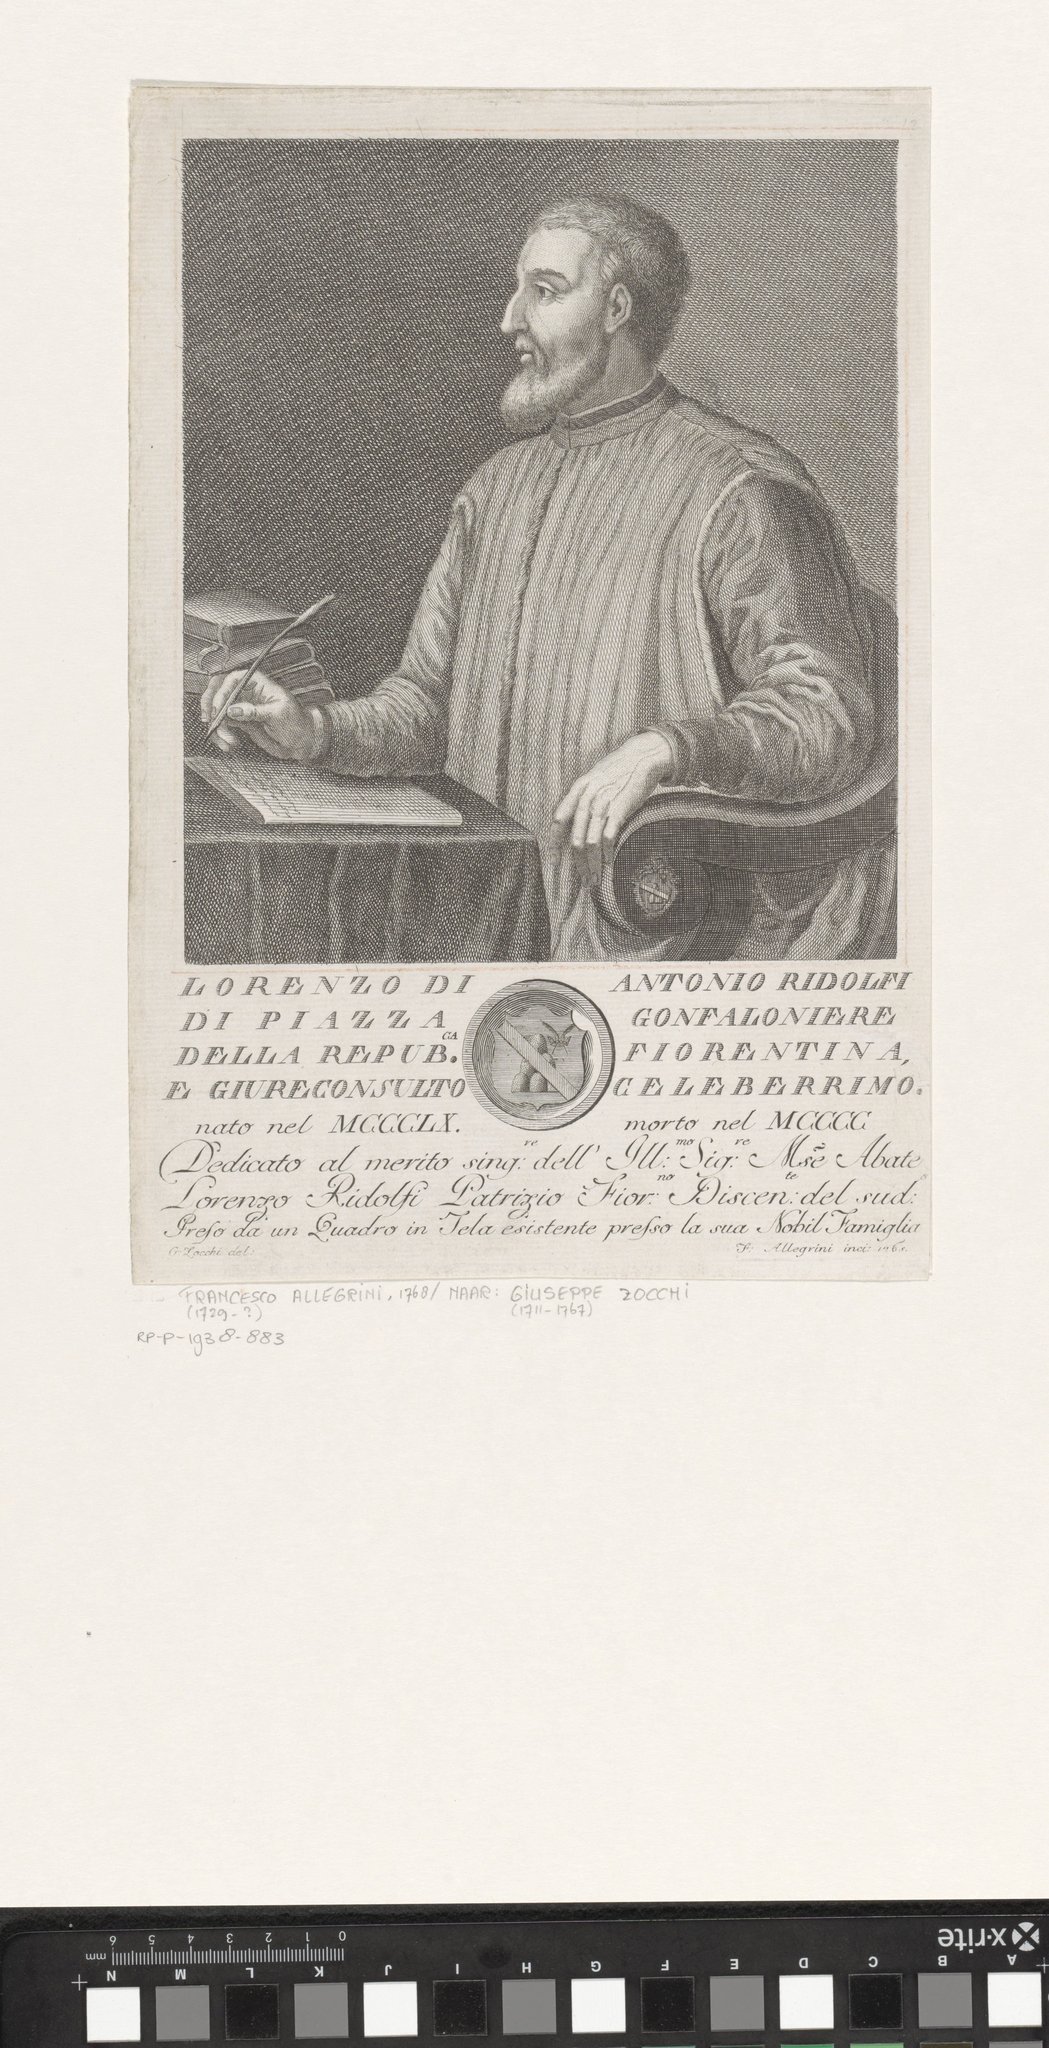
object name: print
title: Portretten van beroemde Italianen met wapenschild in ondermarge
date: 1765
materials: paper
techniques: engraving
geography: italy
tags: historical persons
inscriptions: collector's mark: Lugt 2228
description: Portret van jurist Lorenzo Antonio Ridolfi ten halven lijve, zittend achter een bureau met een schrijfveer in zijn rechterhand. Op het bureau een stapel boeken. Onder het portret een tekst in het Italiaans en een wapenschild in een cirkelvormig kader.